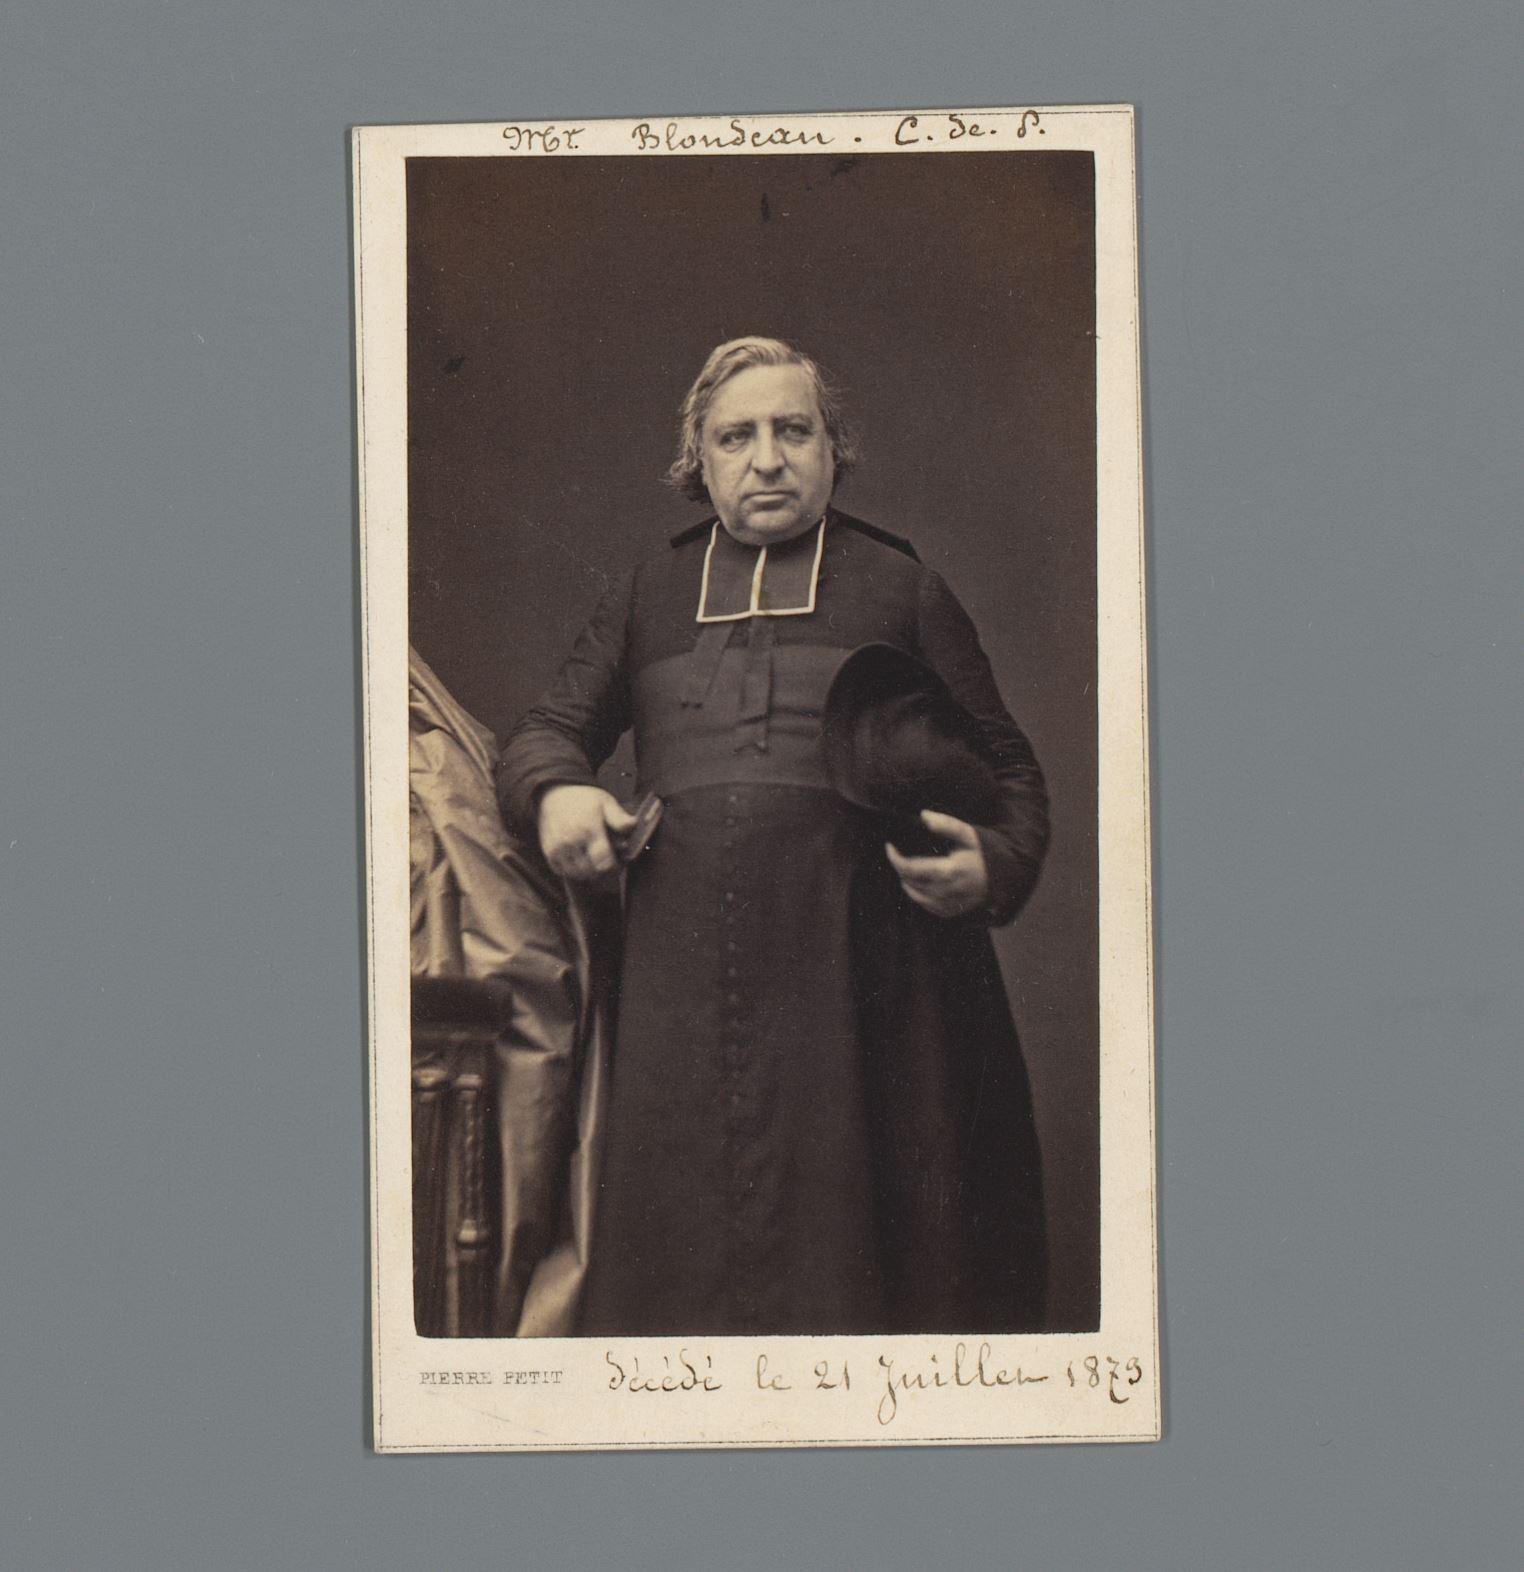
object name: photograph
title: Portret van een geestelijke genaamd Blondeau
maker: pierre petit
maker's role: fotograaf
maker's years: 1832-1909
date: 1859-1873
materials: cardboard, paper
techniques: albumen print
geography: paris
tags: clergyman, historical persons, organization, functionaries and dignitaries in roman catholic church; clergy in general, paris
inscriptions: inscription: ‘Pierre Petit’, inscription: ‘Photographie des deux mondes/ exposition universelle/ Paris Besançon/ Pierre Petit,/ photographe/ 31, Place Cadet/ Paris’, inscription: ‘Mr Blondeau. C. de P./ décedé le 21 Juillet 1879’